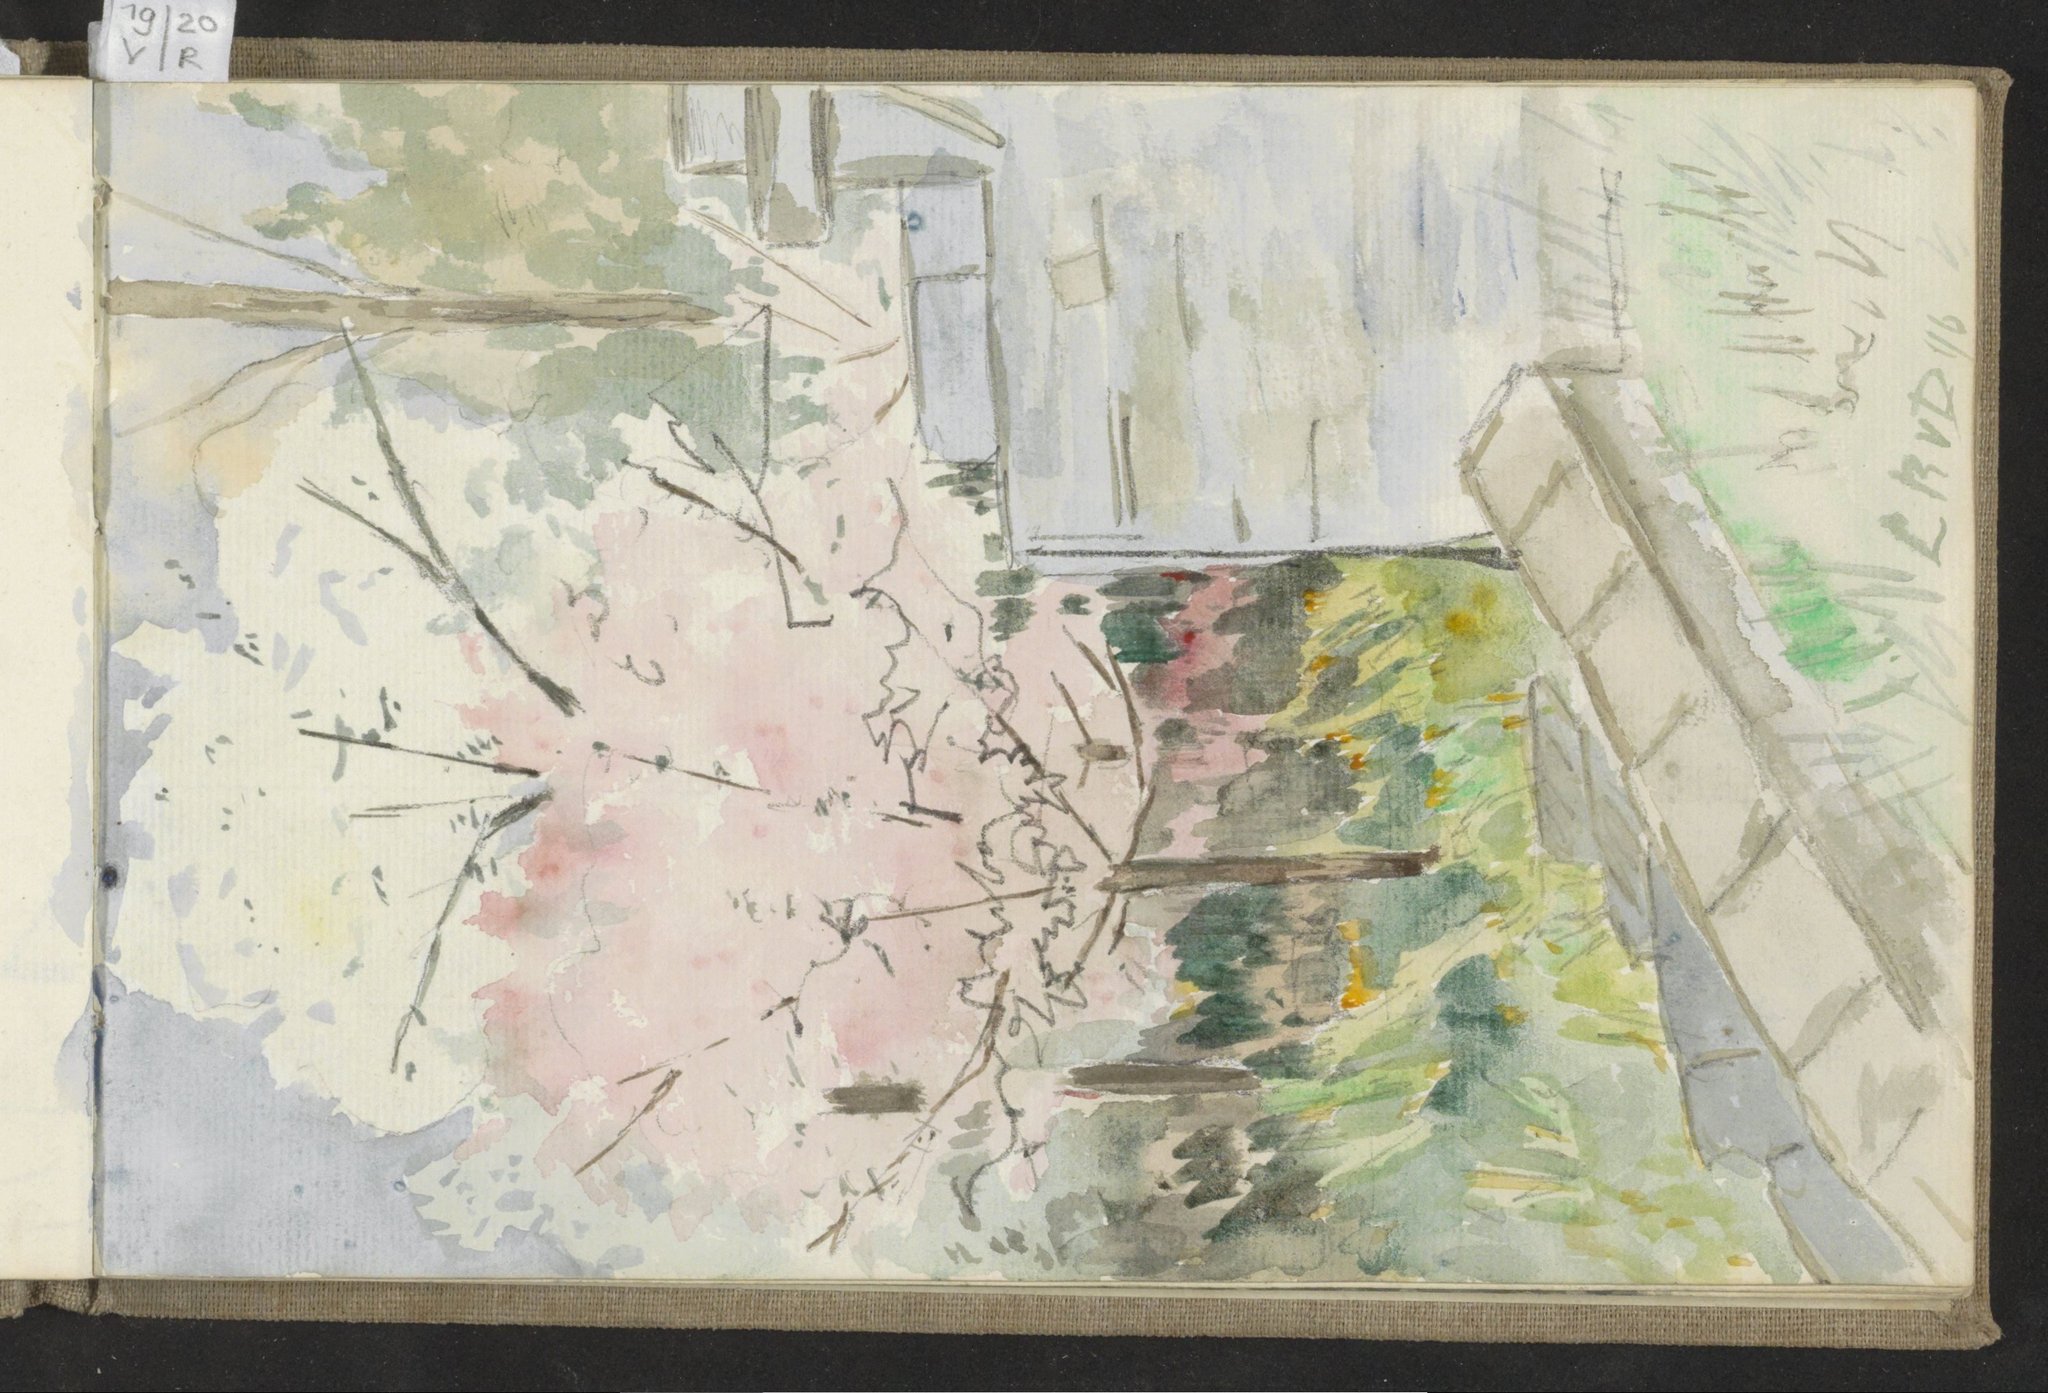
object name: sketchbook leaf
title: Bomen naast een huis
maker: jonkheer johannes ludovicus paulus bosch van drakestein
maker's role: draughtsman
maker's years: 1865-1929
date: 1896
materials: paper, pencil, watercolor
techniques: brush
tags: trees, fence, wall, paling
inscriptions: signature and date: ‘LBvD 96’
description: Blad 19 recto uit een schetsboek met 58 bladen.